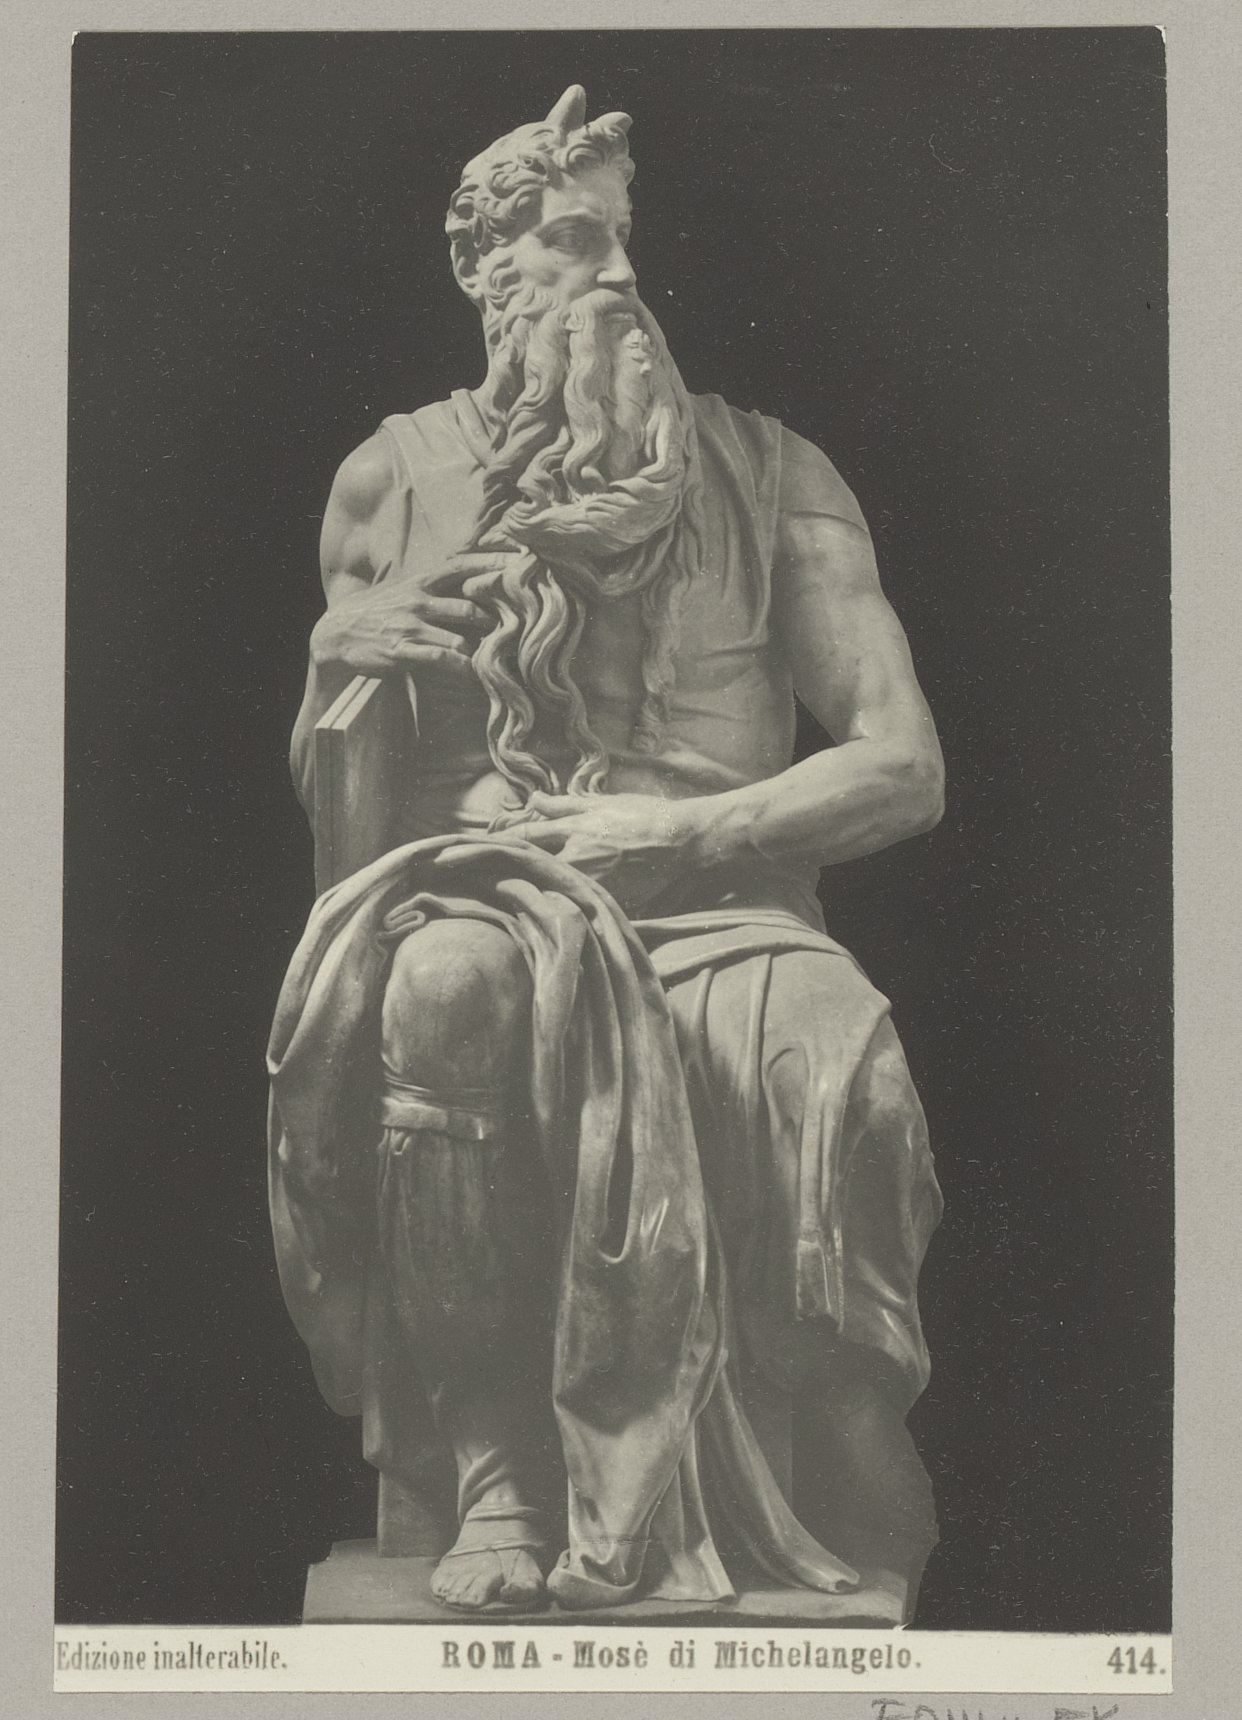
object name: photograph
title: Beeld van Mozes in de San Pietro in Vincoli in Rome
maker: Anonymous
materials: photographic support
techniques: gelatin silver print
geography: san pietro in vincoli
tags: piece of sculpture, reproduction of a piece of sculpture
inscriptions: number: ‘414’, inscription: ‘Edizione inalterabile’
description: Onderdeel van Fotoalbum van een reis door Zuid-Europa en het Midden-Oosten.